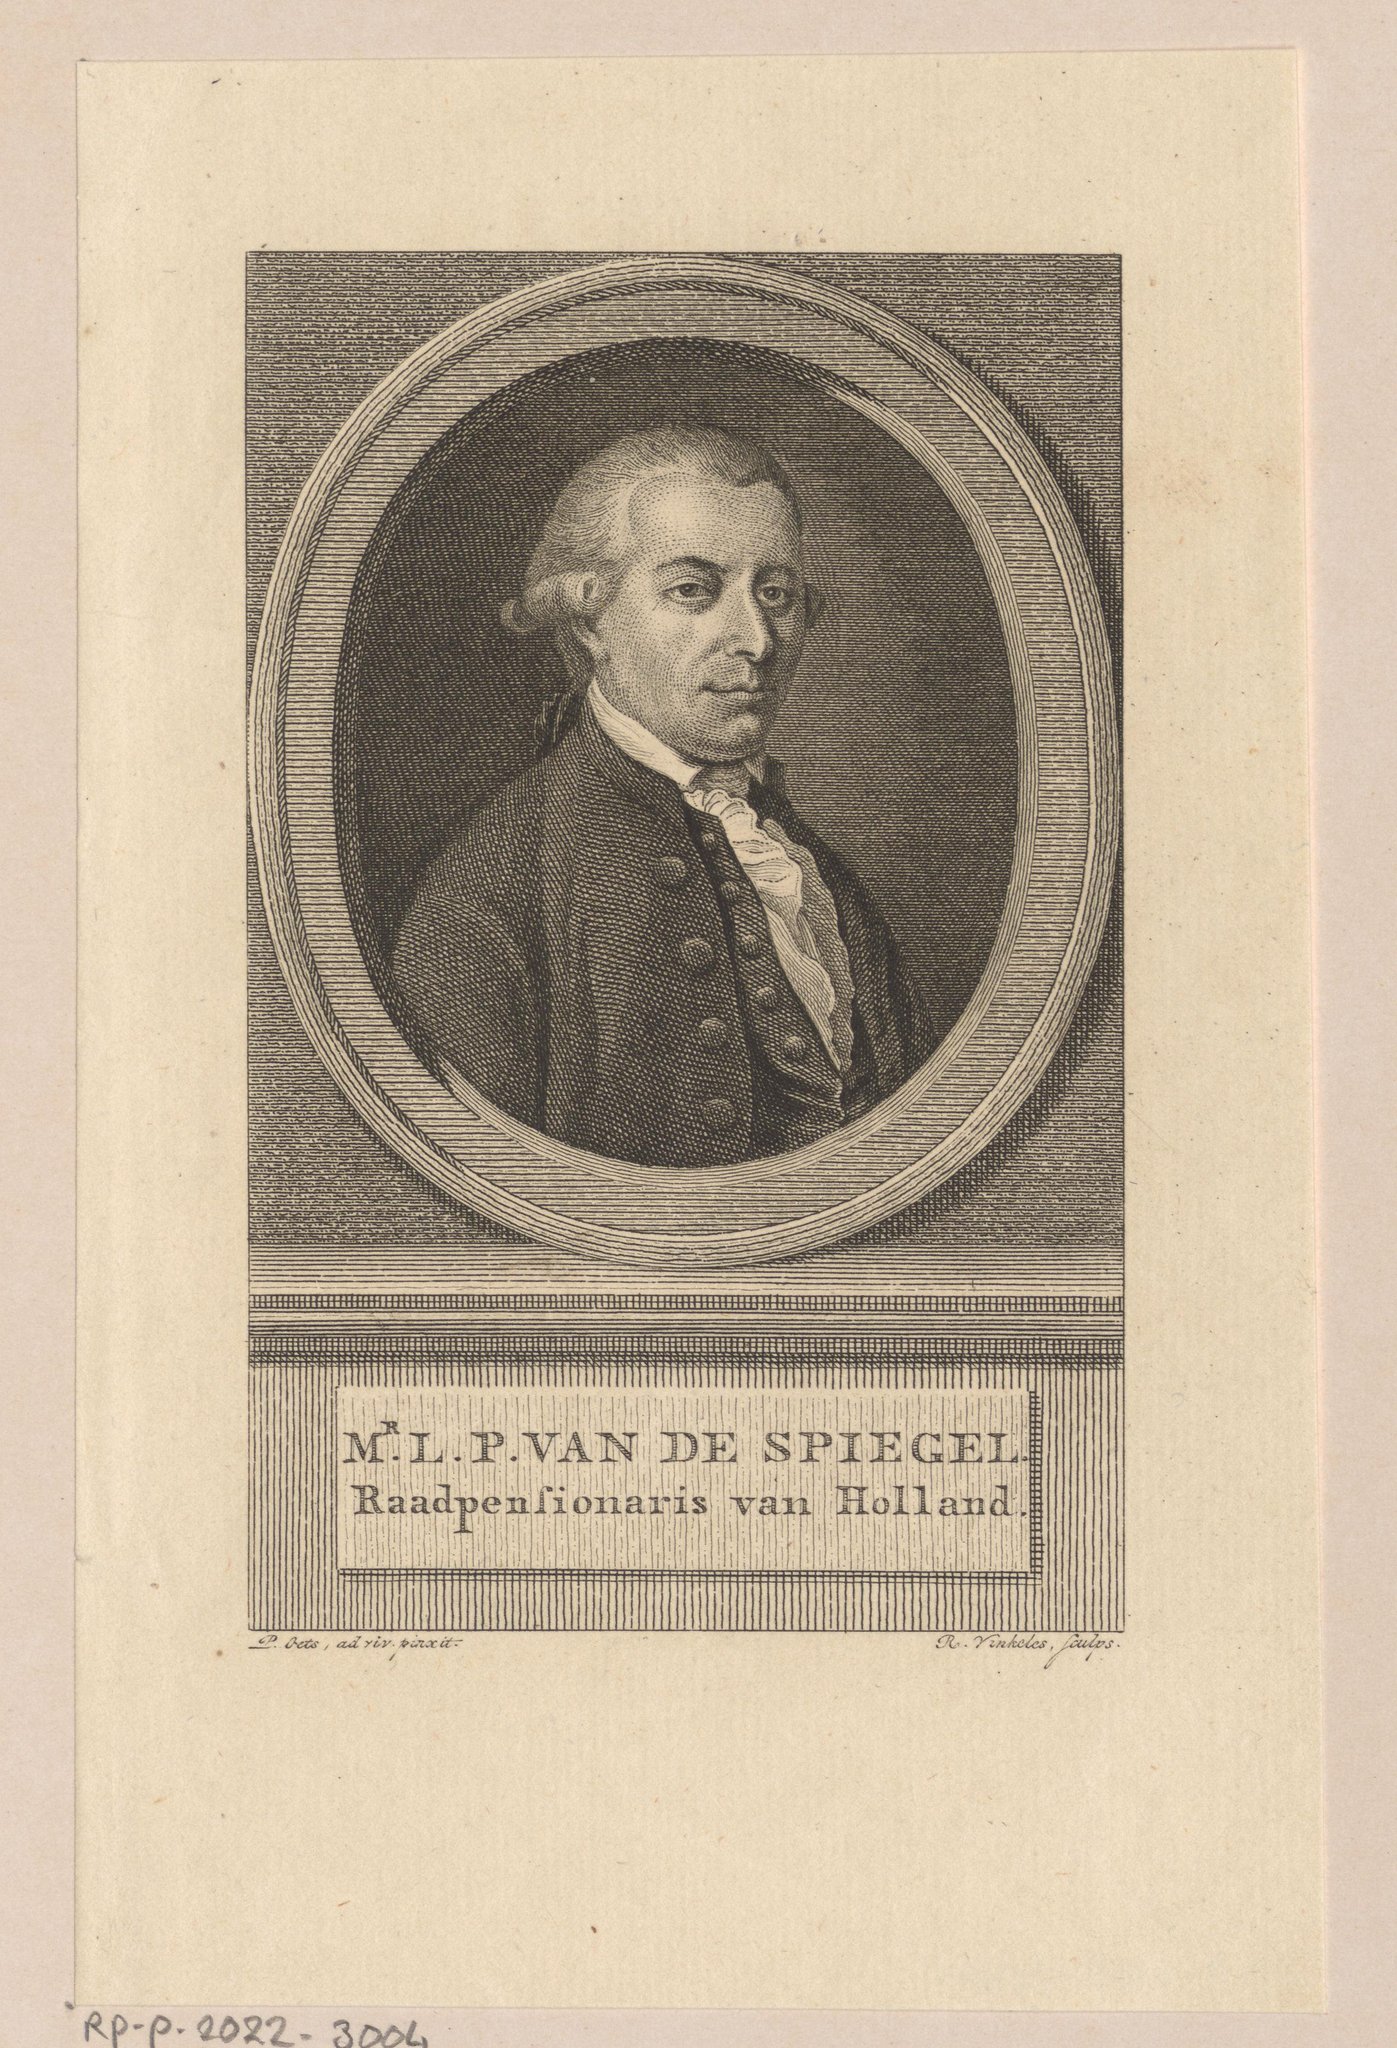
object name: print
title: Portret van Laurens Pieter van de Spiegel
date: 1801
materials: paper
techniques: etching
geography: amsterdam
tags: historical persons, politician, e.g. party leader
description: Prent waarschijnlijk uit: Wagenaar, Jan. Vaderlandsche historie vervattende de geschiedenissen der Vereenigde Nederlanden (...). Amsterdam: Johannes Allart, 1801, dl. 27.